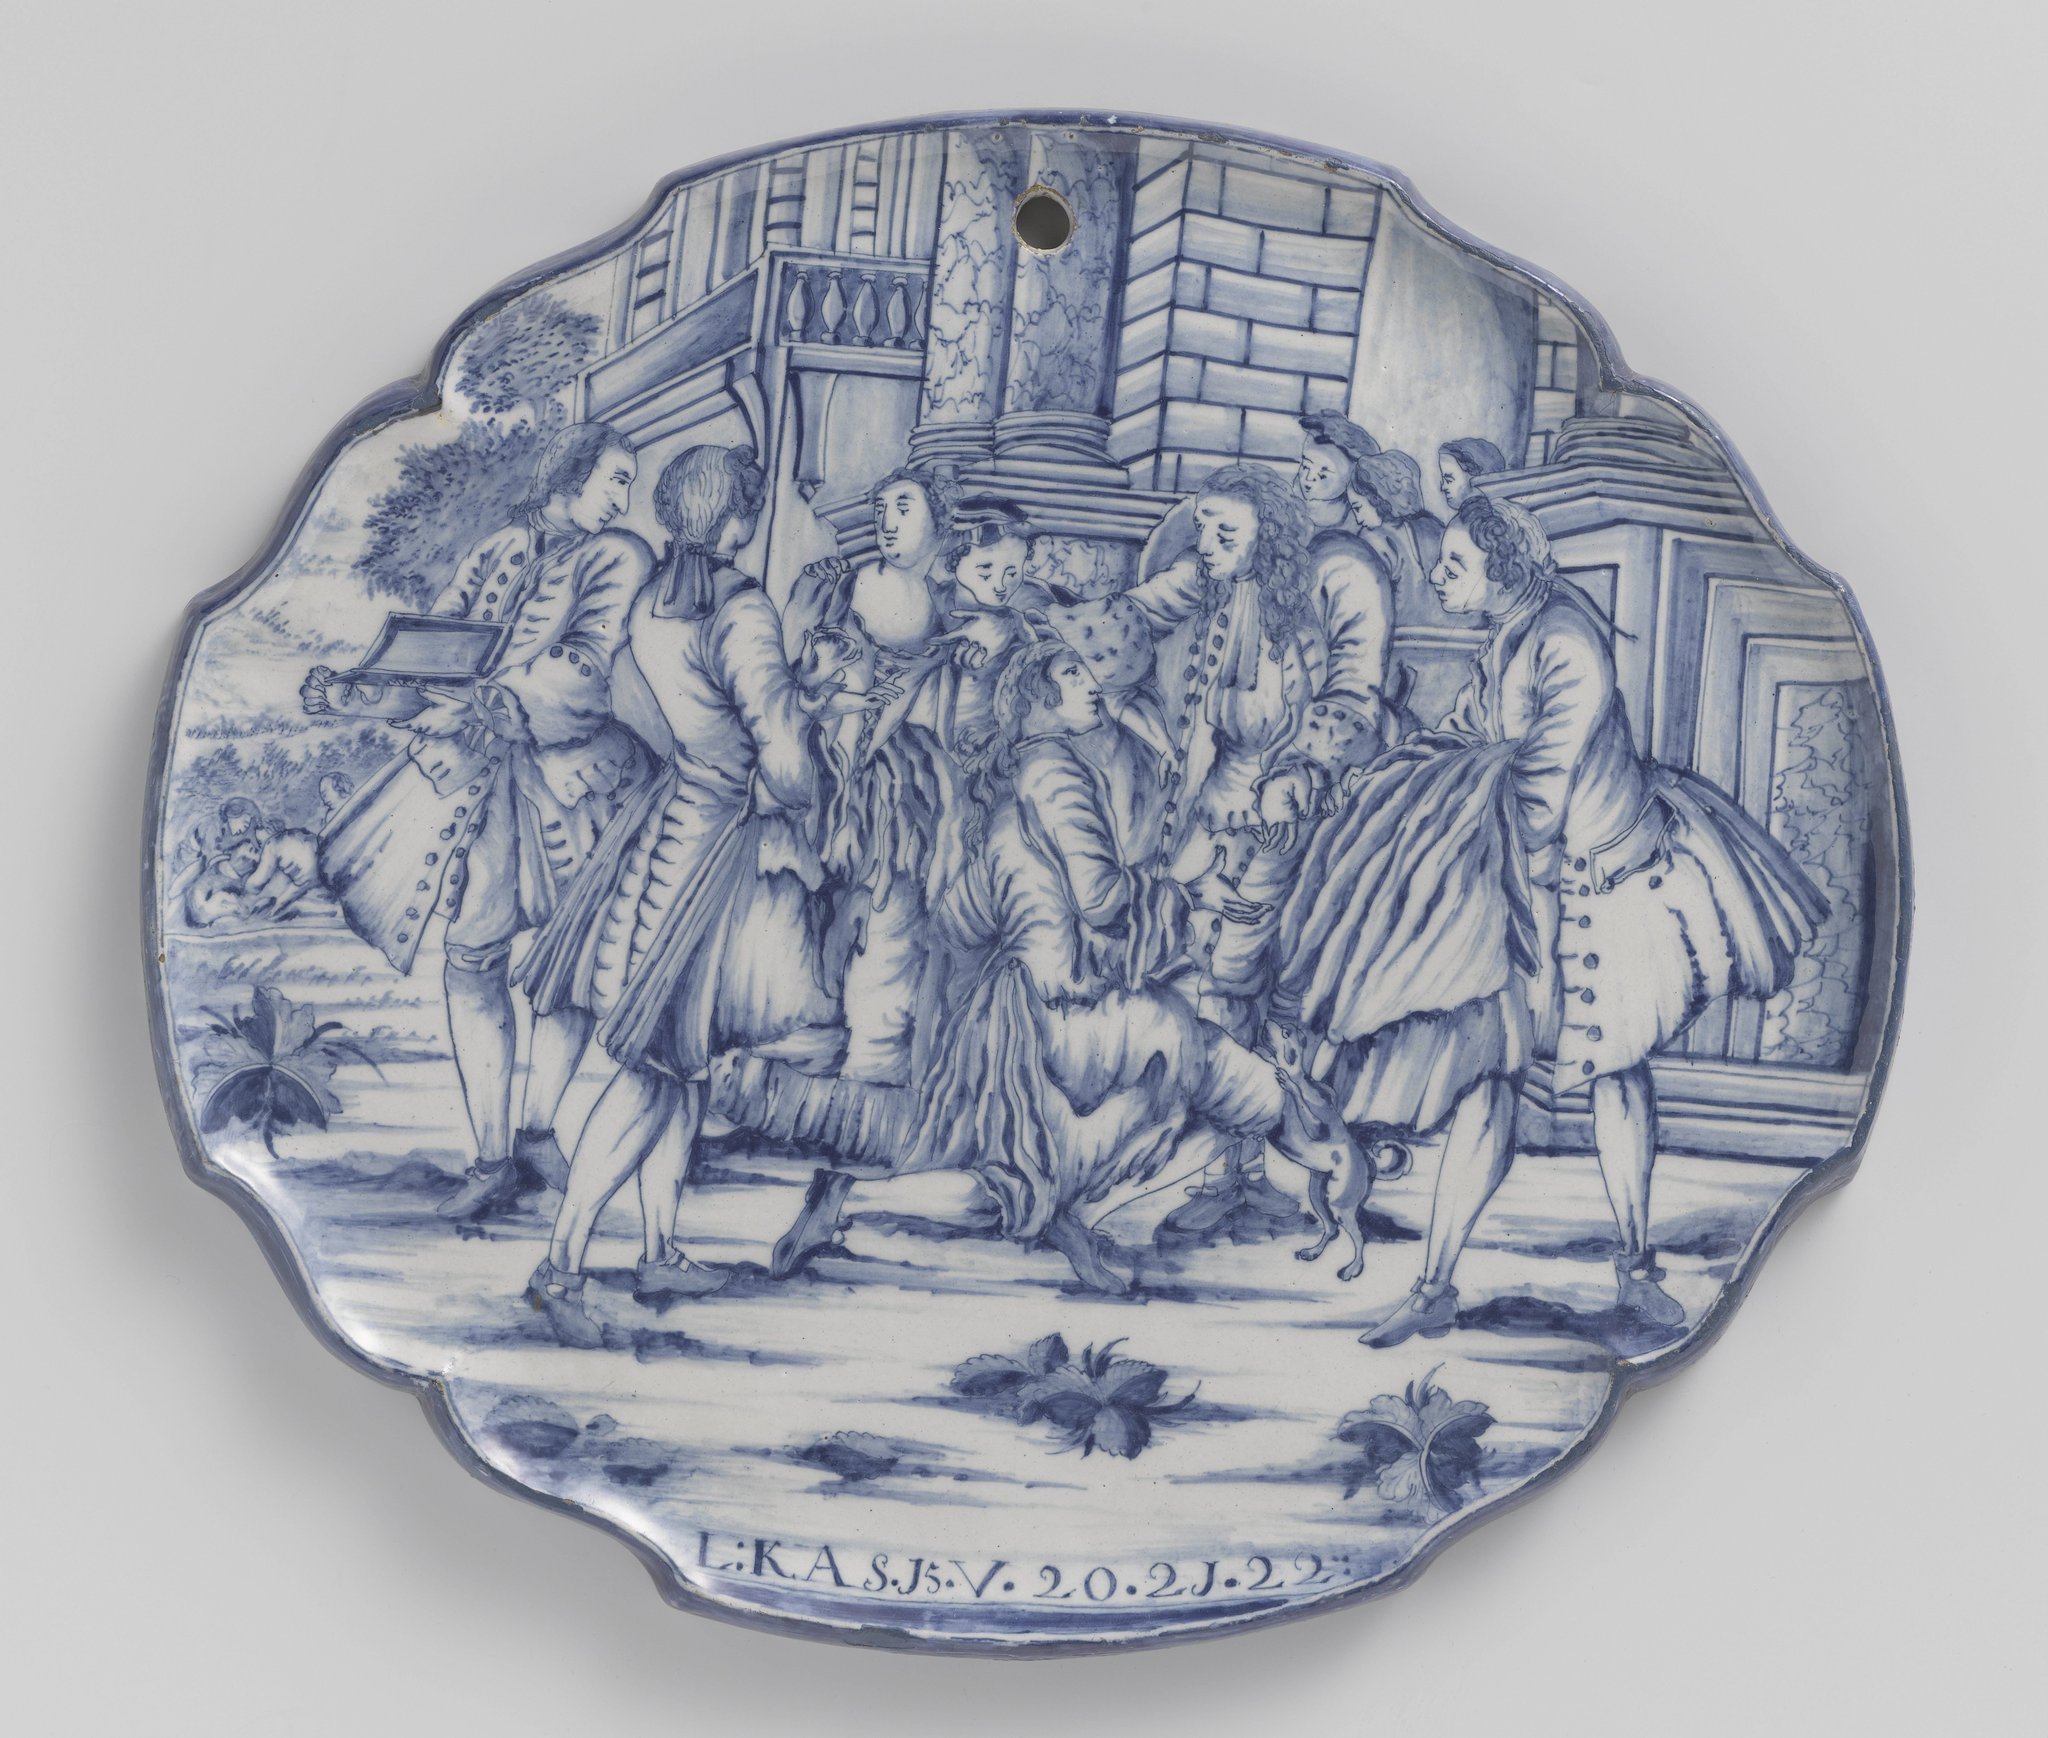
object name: plate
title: Plaque with the Return of the Prodigal Son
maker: Anonymous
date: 1740-1770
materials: earthenware, glaze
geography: delft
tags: the prodigal son returns home, where his father awaits him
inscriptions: inscription: ‘L:KAS.J5.V.20.2J.22’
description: Plaque van faïence. Met de voorstelling van de terugkeer van de verloren zoon.